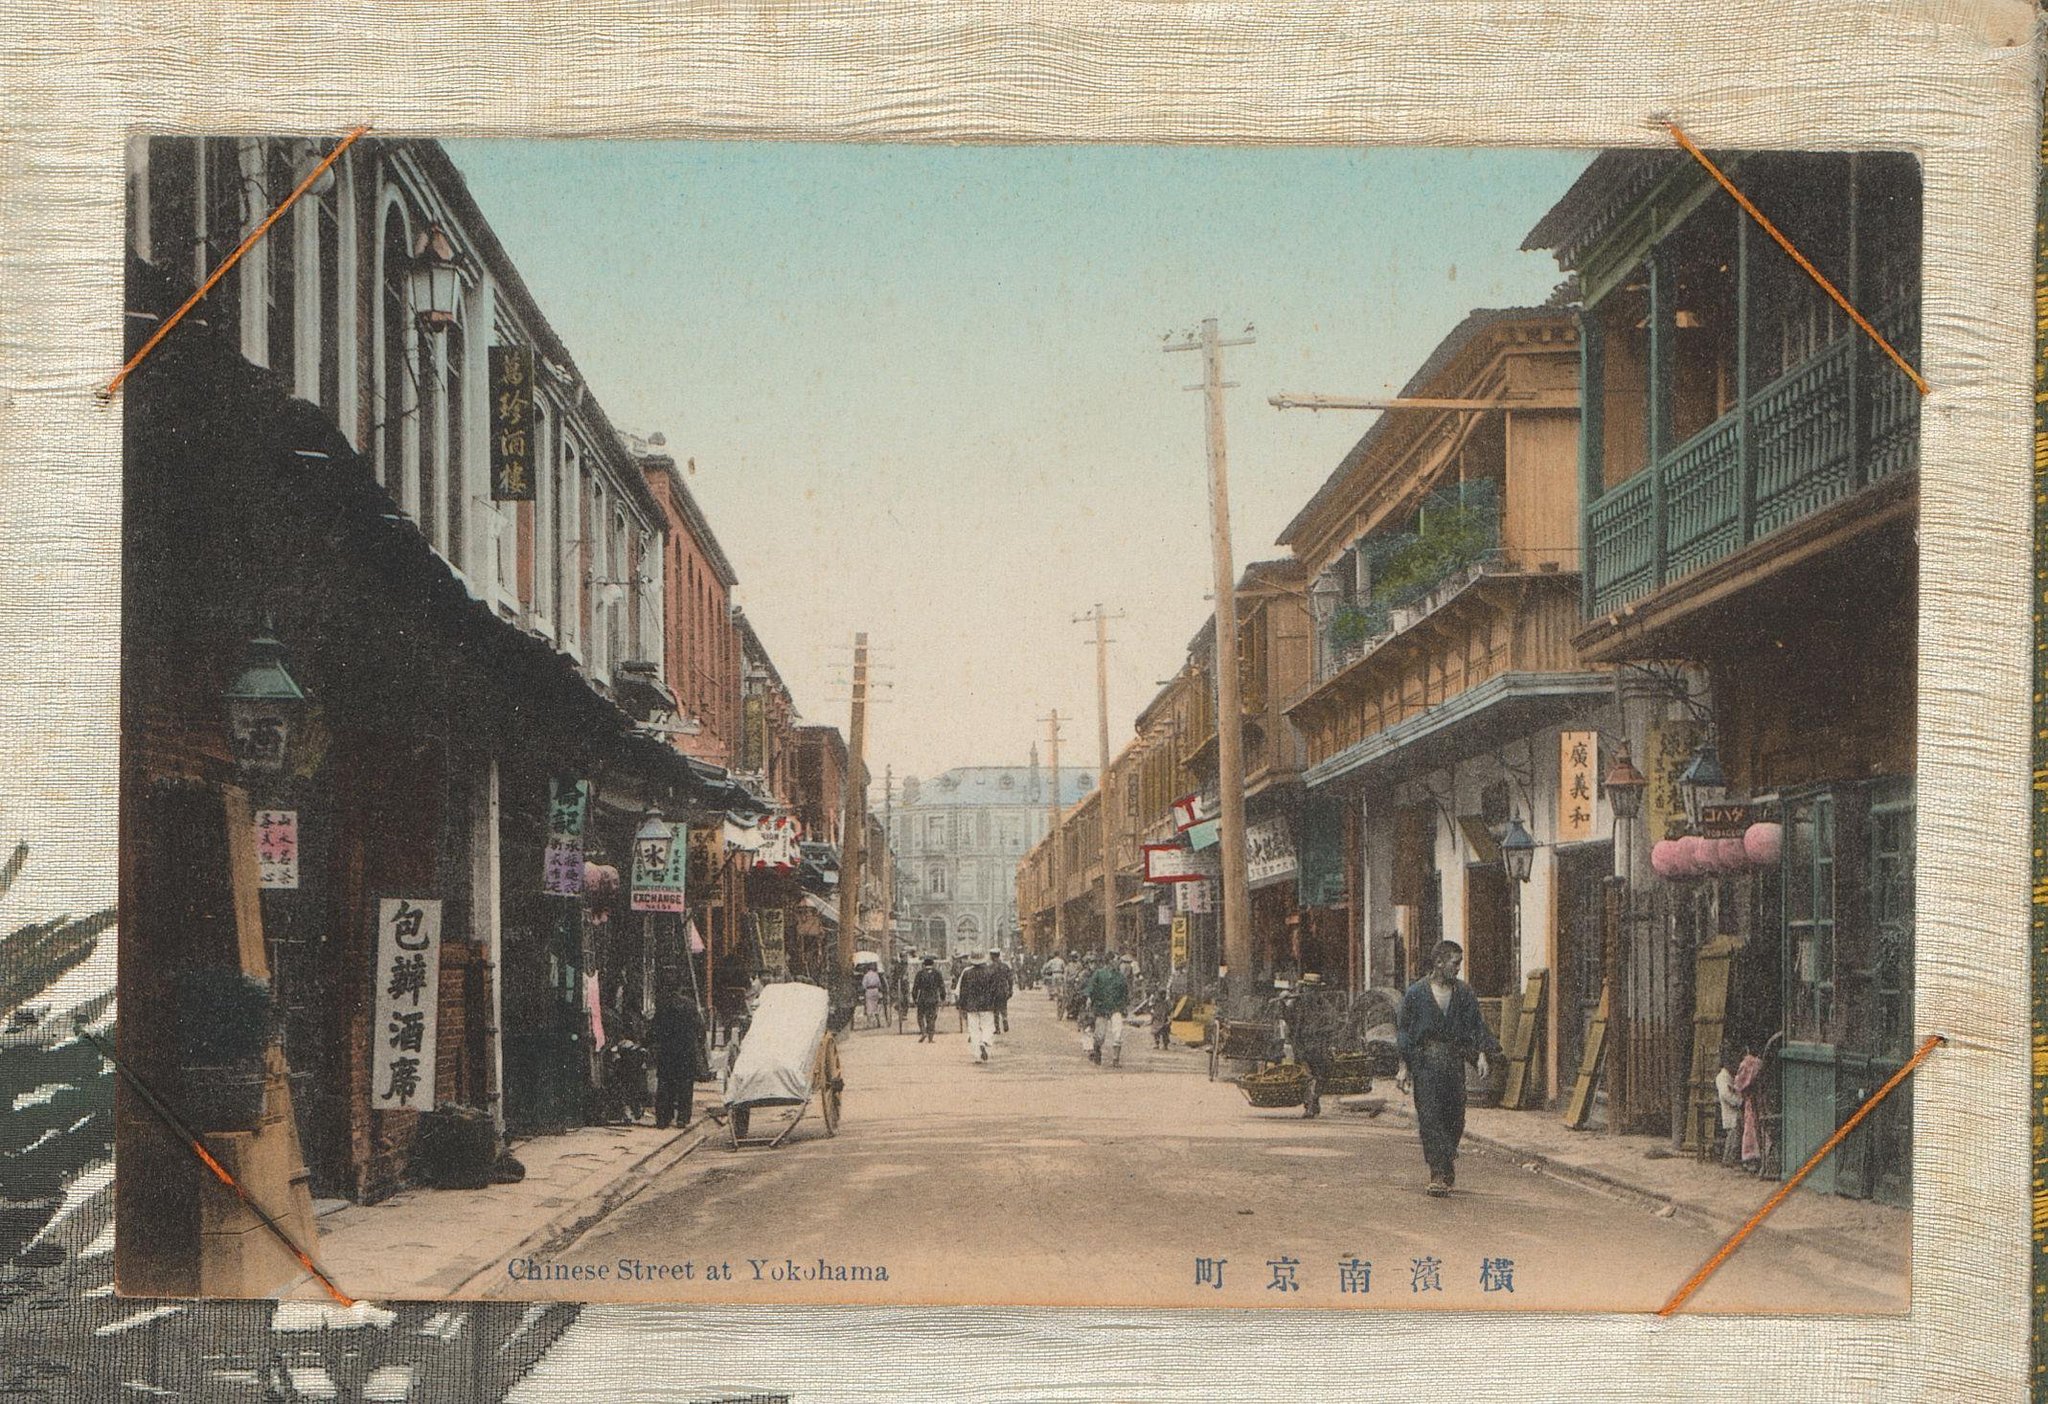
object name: photomechanical print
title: Straatgezicht in Yokohama, Japan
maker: Anonymous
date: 1870-1900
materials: paper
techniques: photograph, hand coloring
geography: yokohama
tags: city-view in general; 'veduta', street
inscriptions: title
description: Deze prent maakt deel uit van een album.